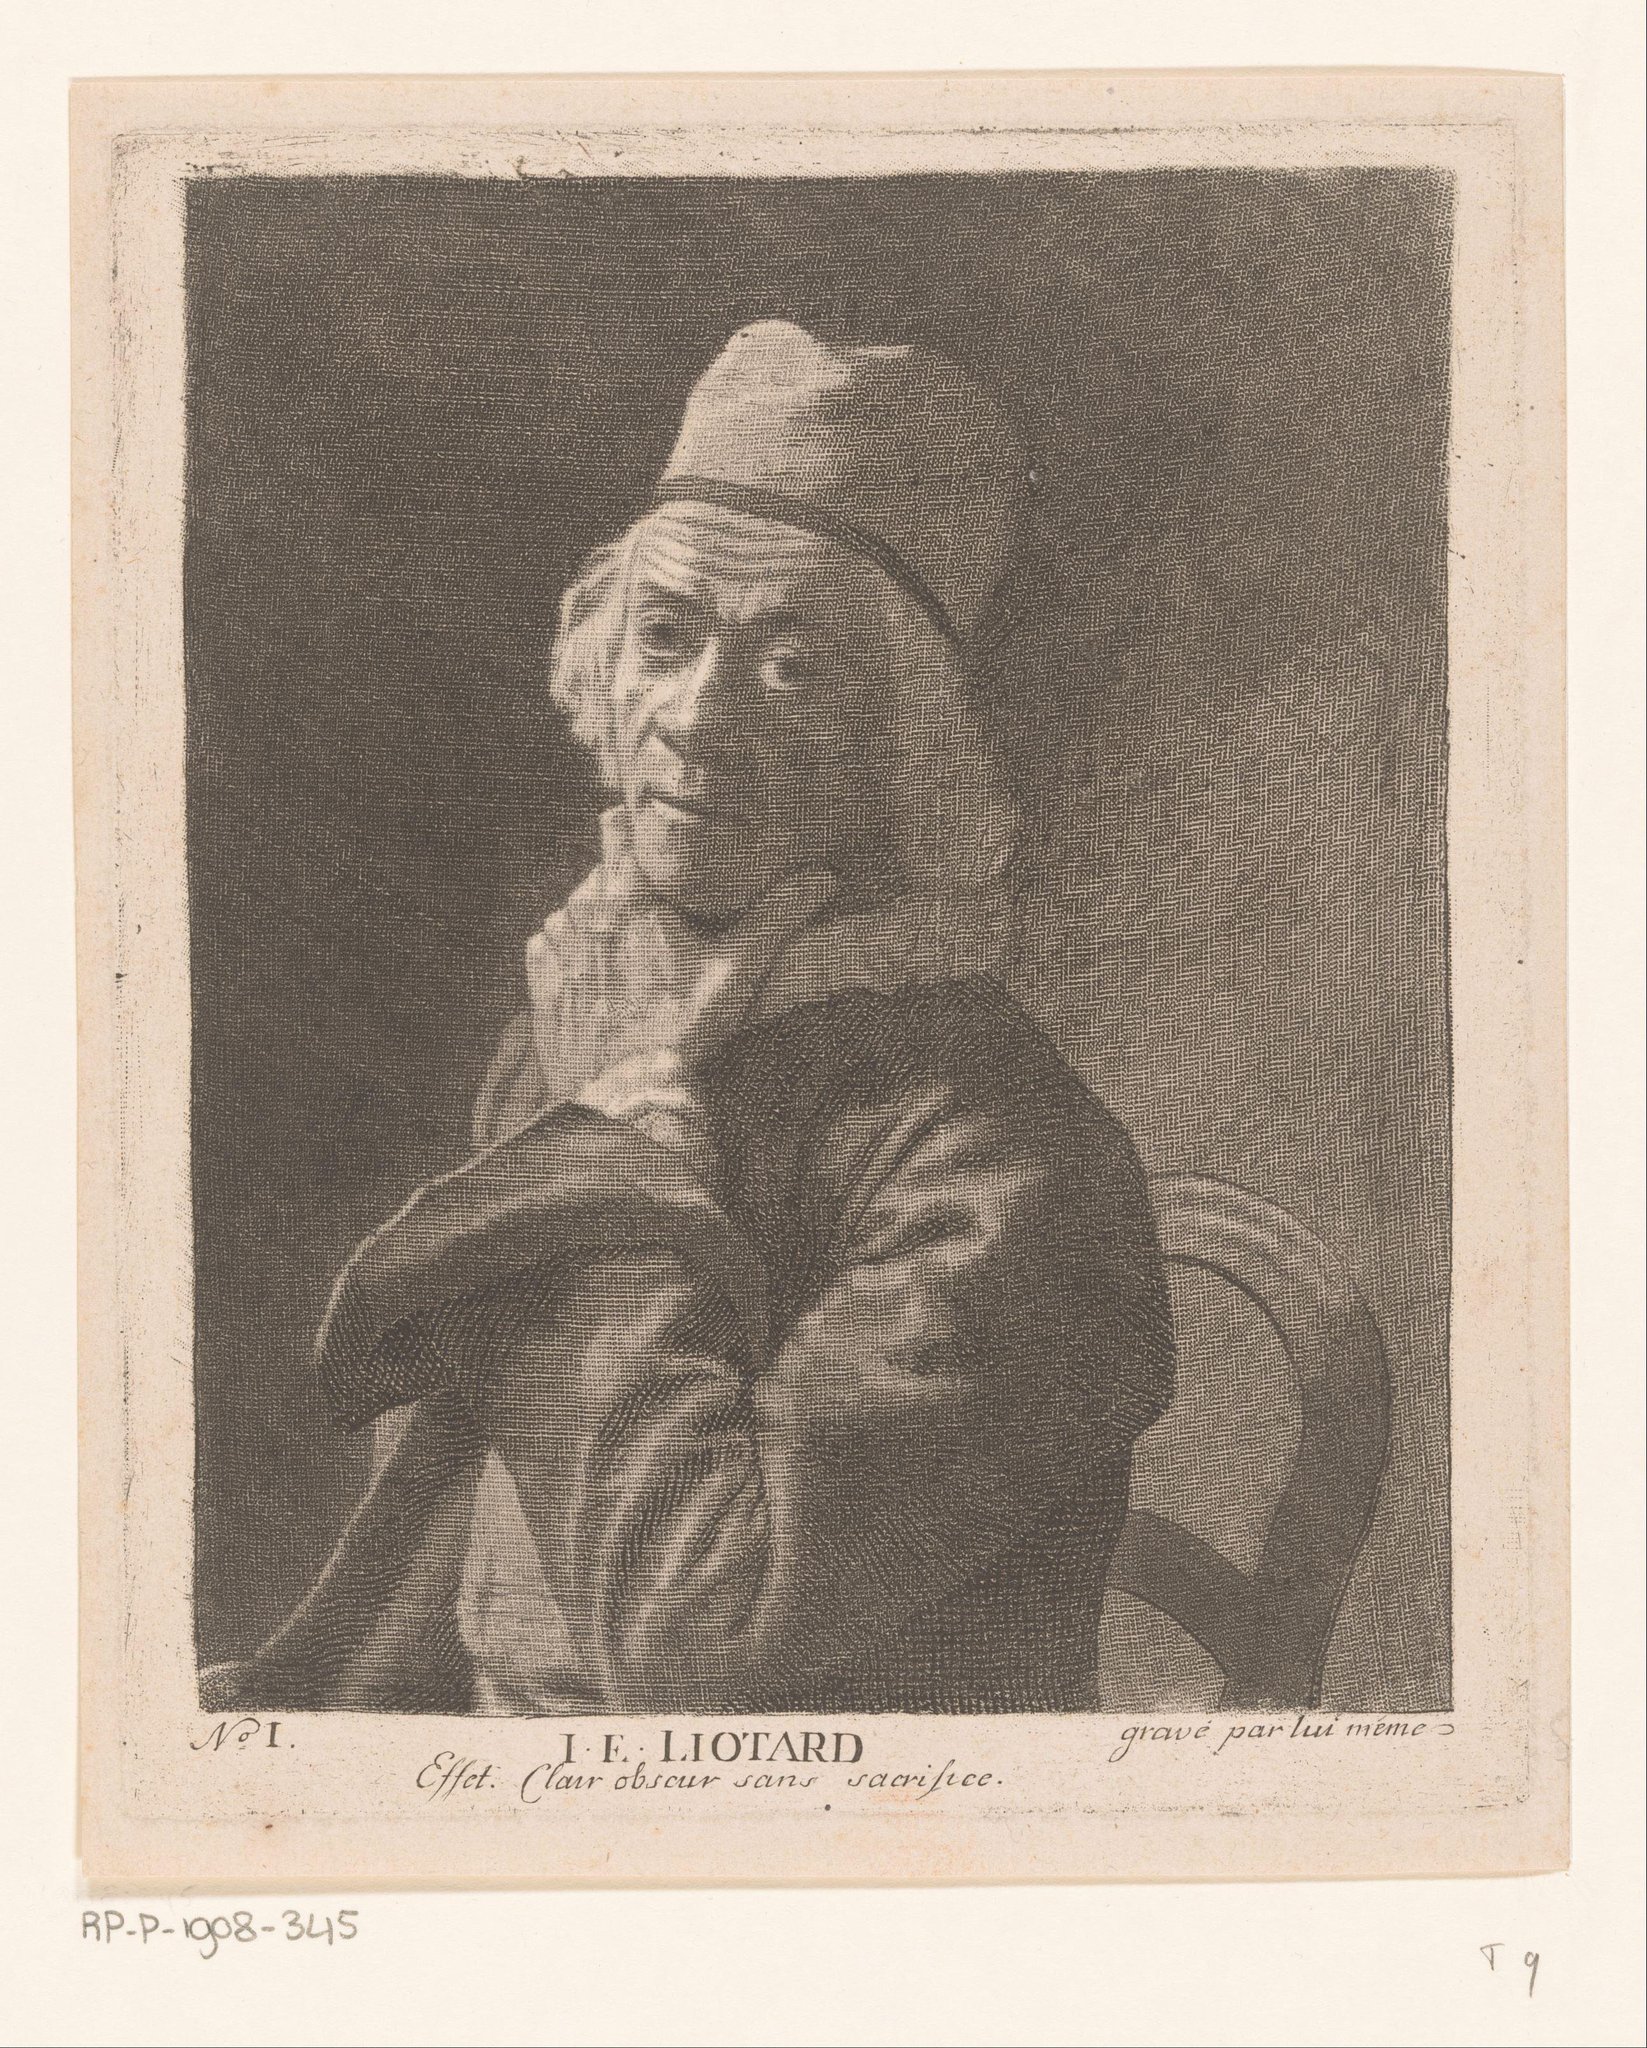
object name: print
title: I.E. Liotard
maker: jean-etienne liotard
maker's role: painter, print maker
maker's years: 1702-1789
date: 1781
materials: paper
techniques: etching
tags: painter, print maker, jean-etienne liotard, historical persons, portrait, self-portrait of graphic artist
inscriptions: collector's mark: Lugt 2228